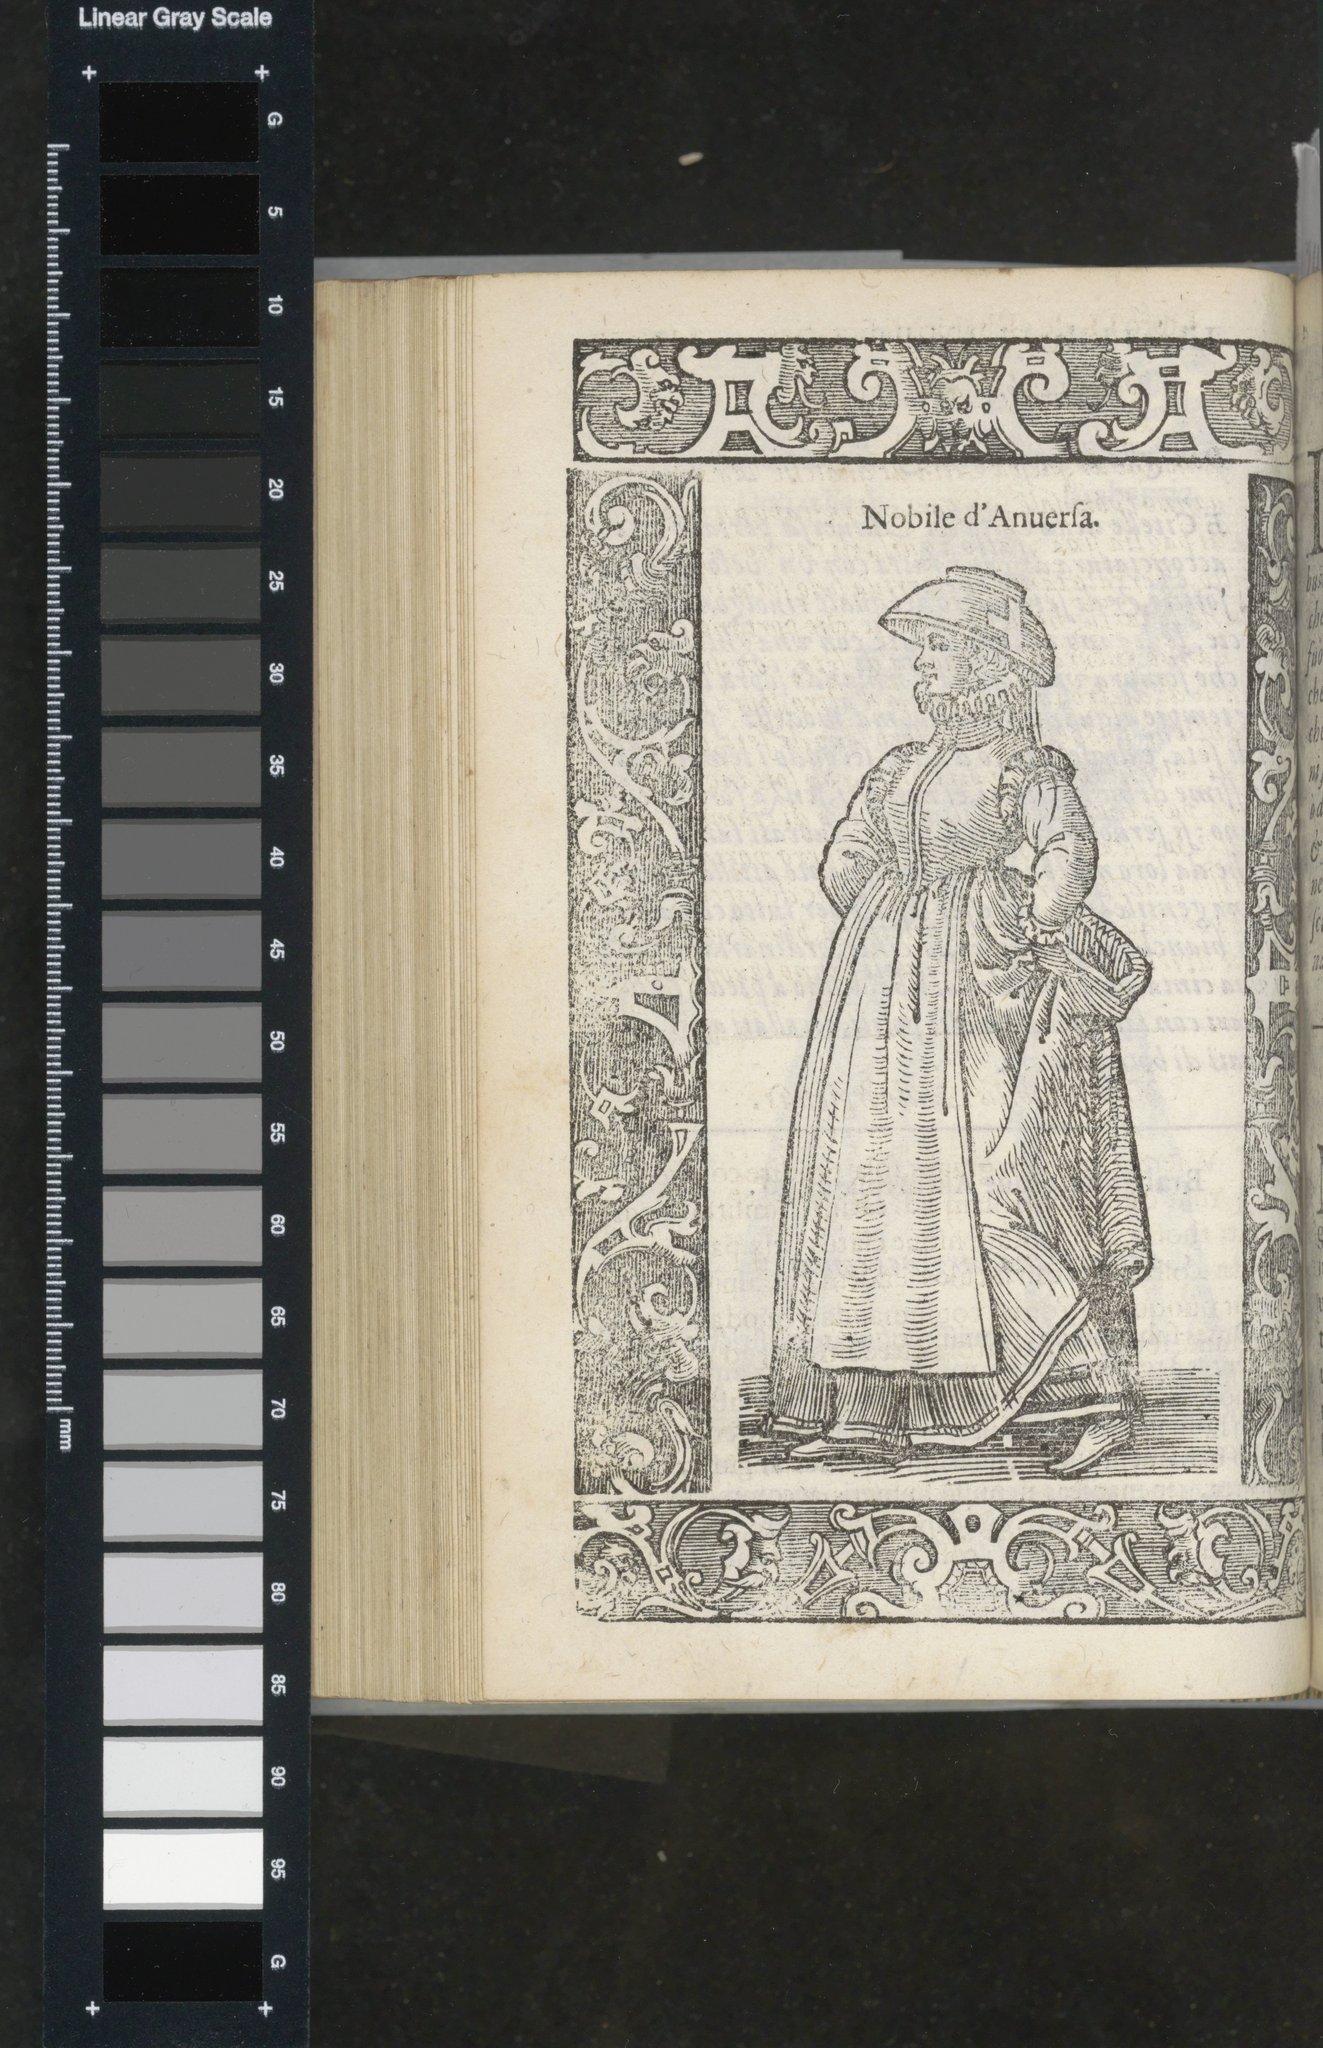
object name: costume print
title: Nobile d’Anversa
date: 1598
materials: paper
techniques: woodcut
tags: fashion plates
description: Adellijke oudere vrouw uit Antwerpen, een strohoed in de vorm van een halve bol op het hoofd. Lang overkleed met schort.